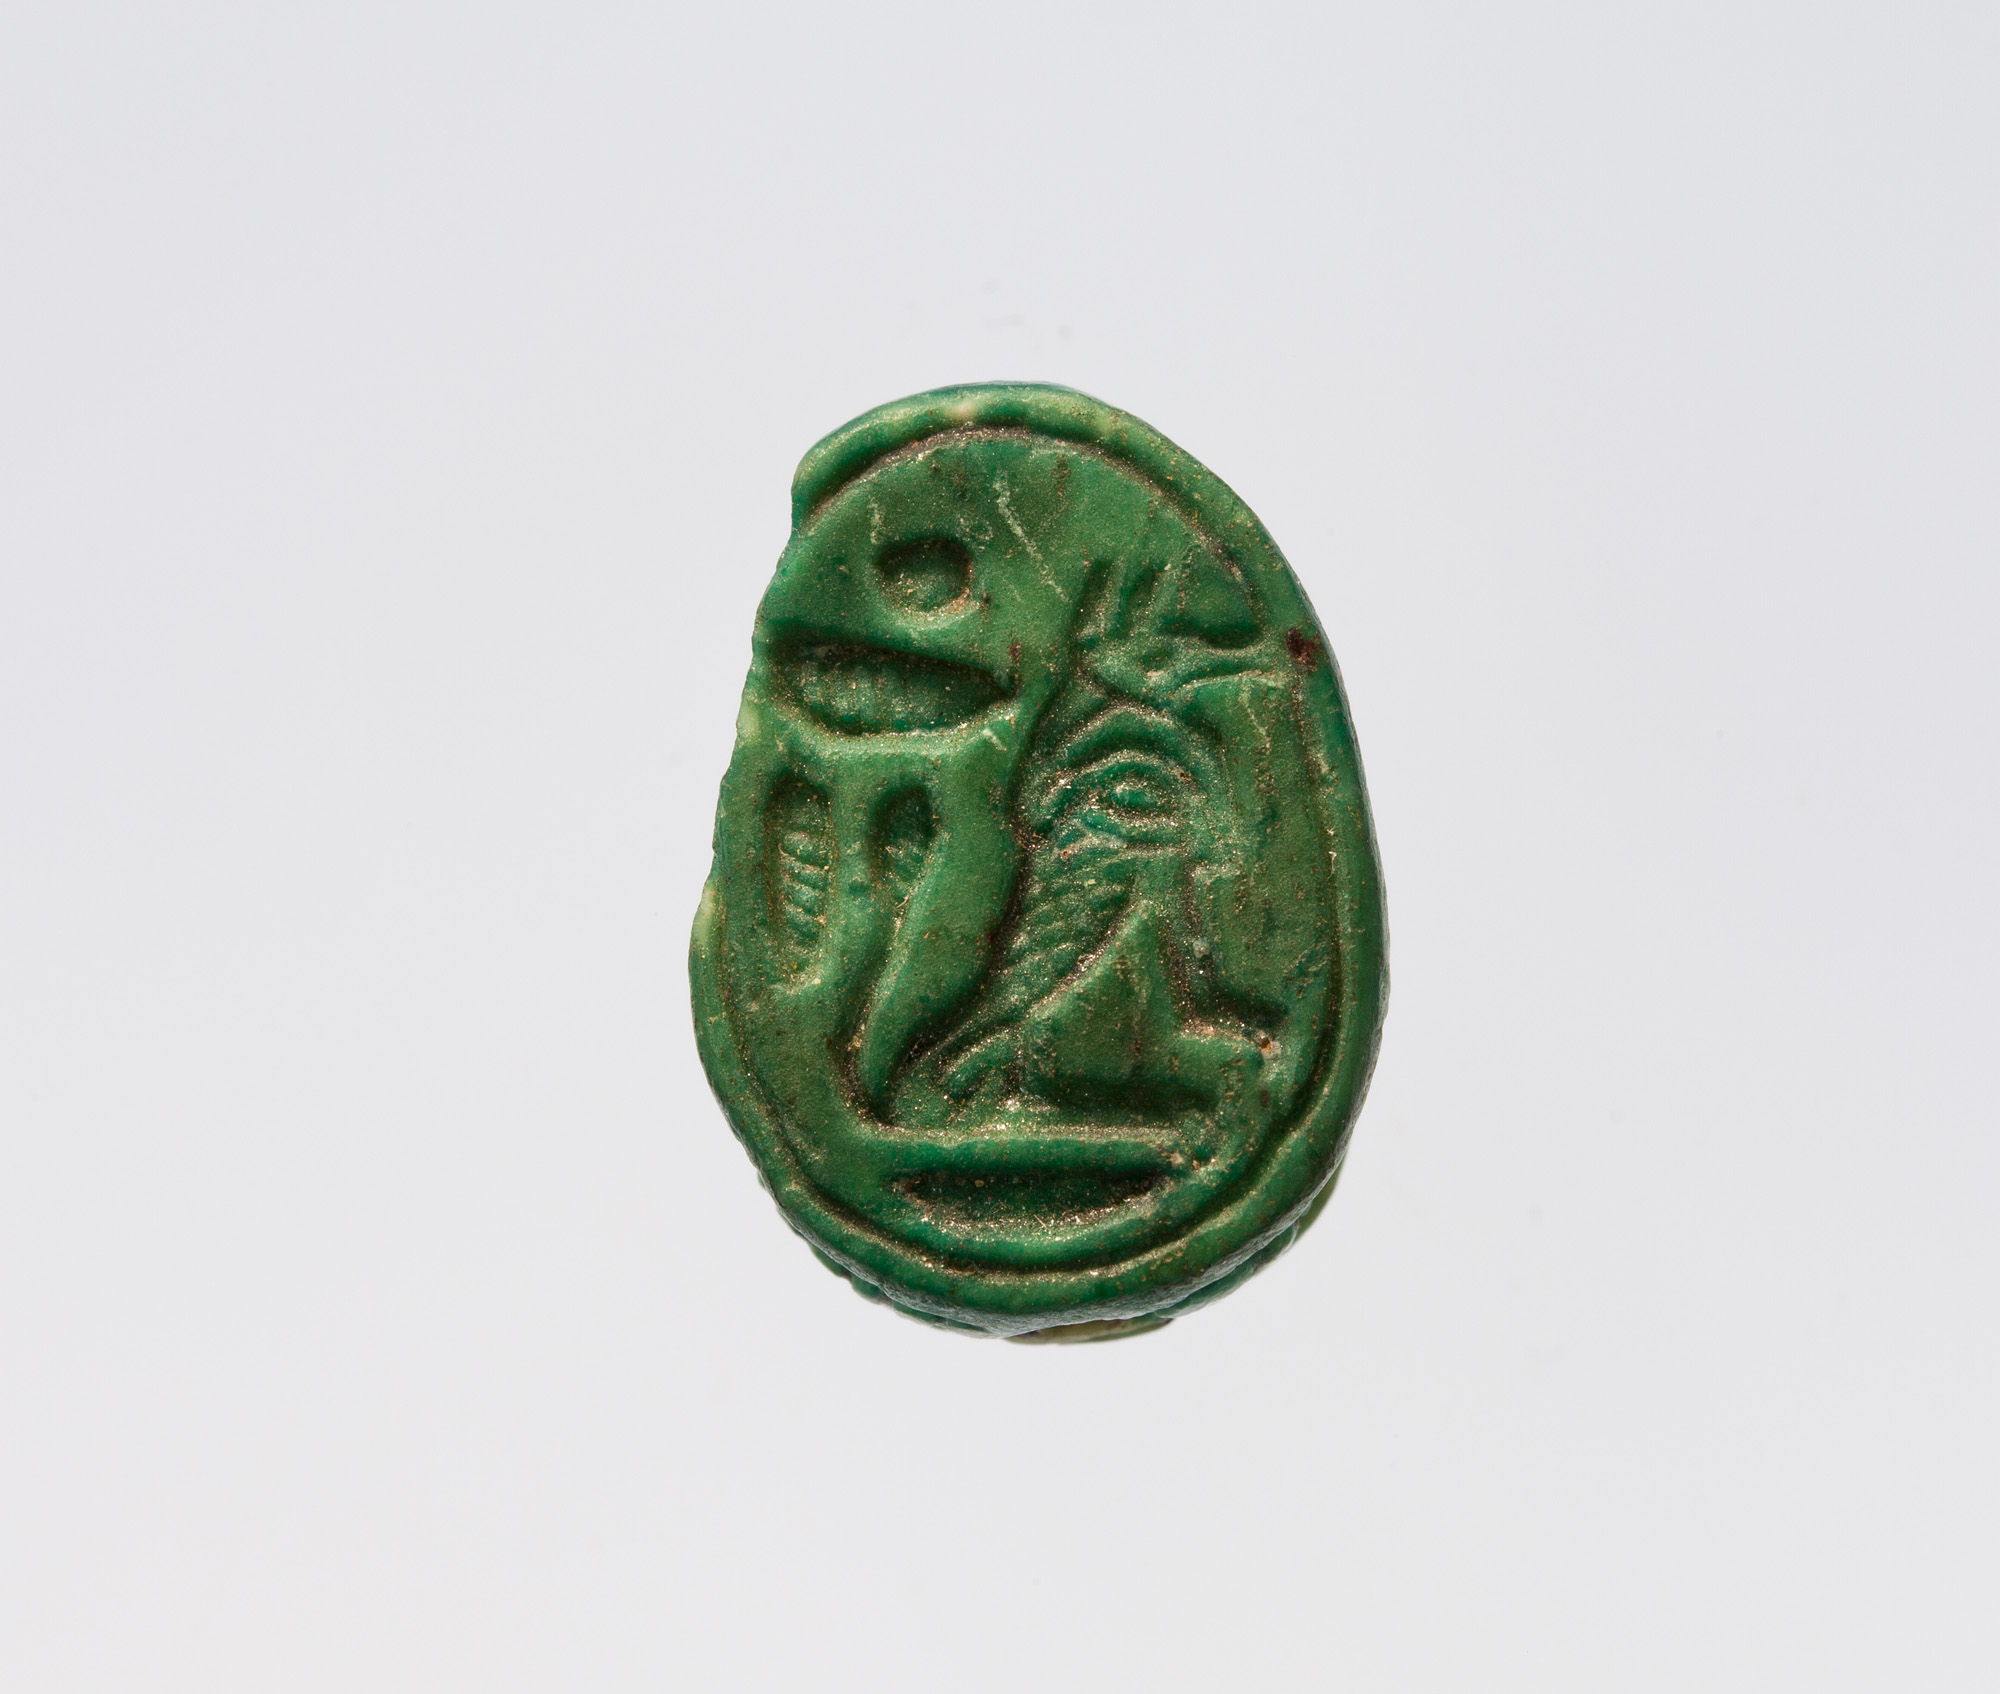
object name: scarab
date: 1479-1458 BCE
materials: faience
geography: egypt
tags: scarabs